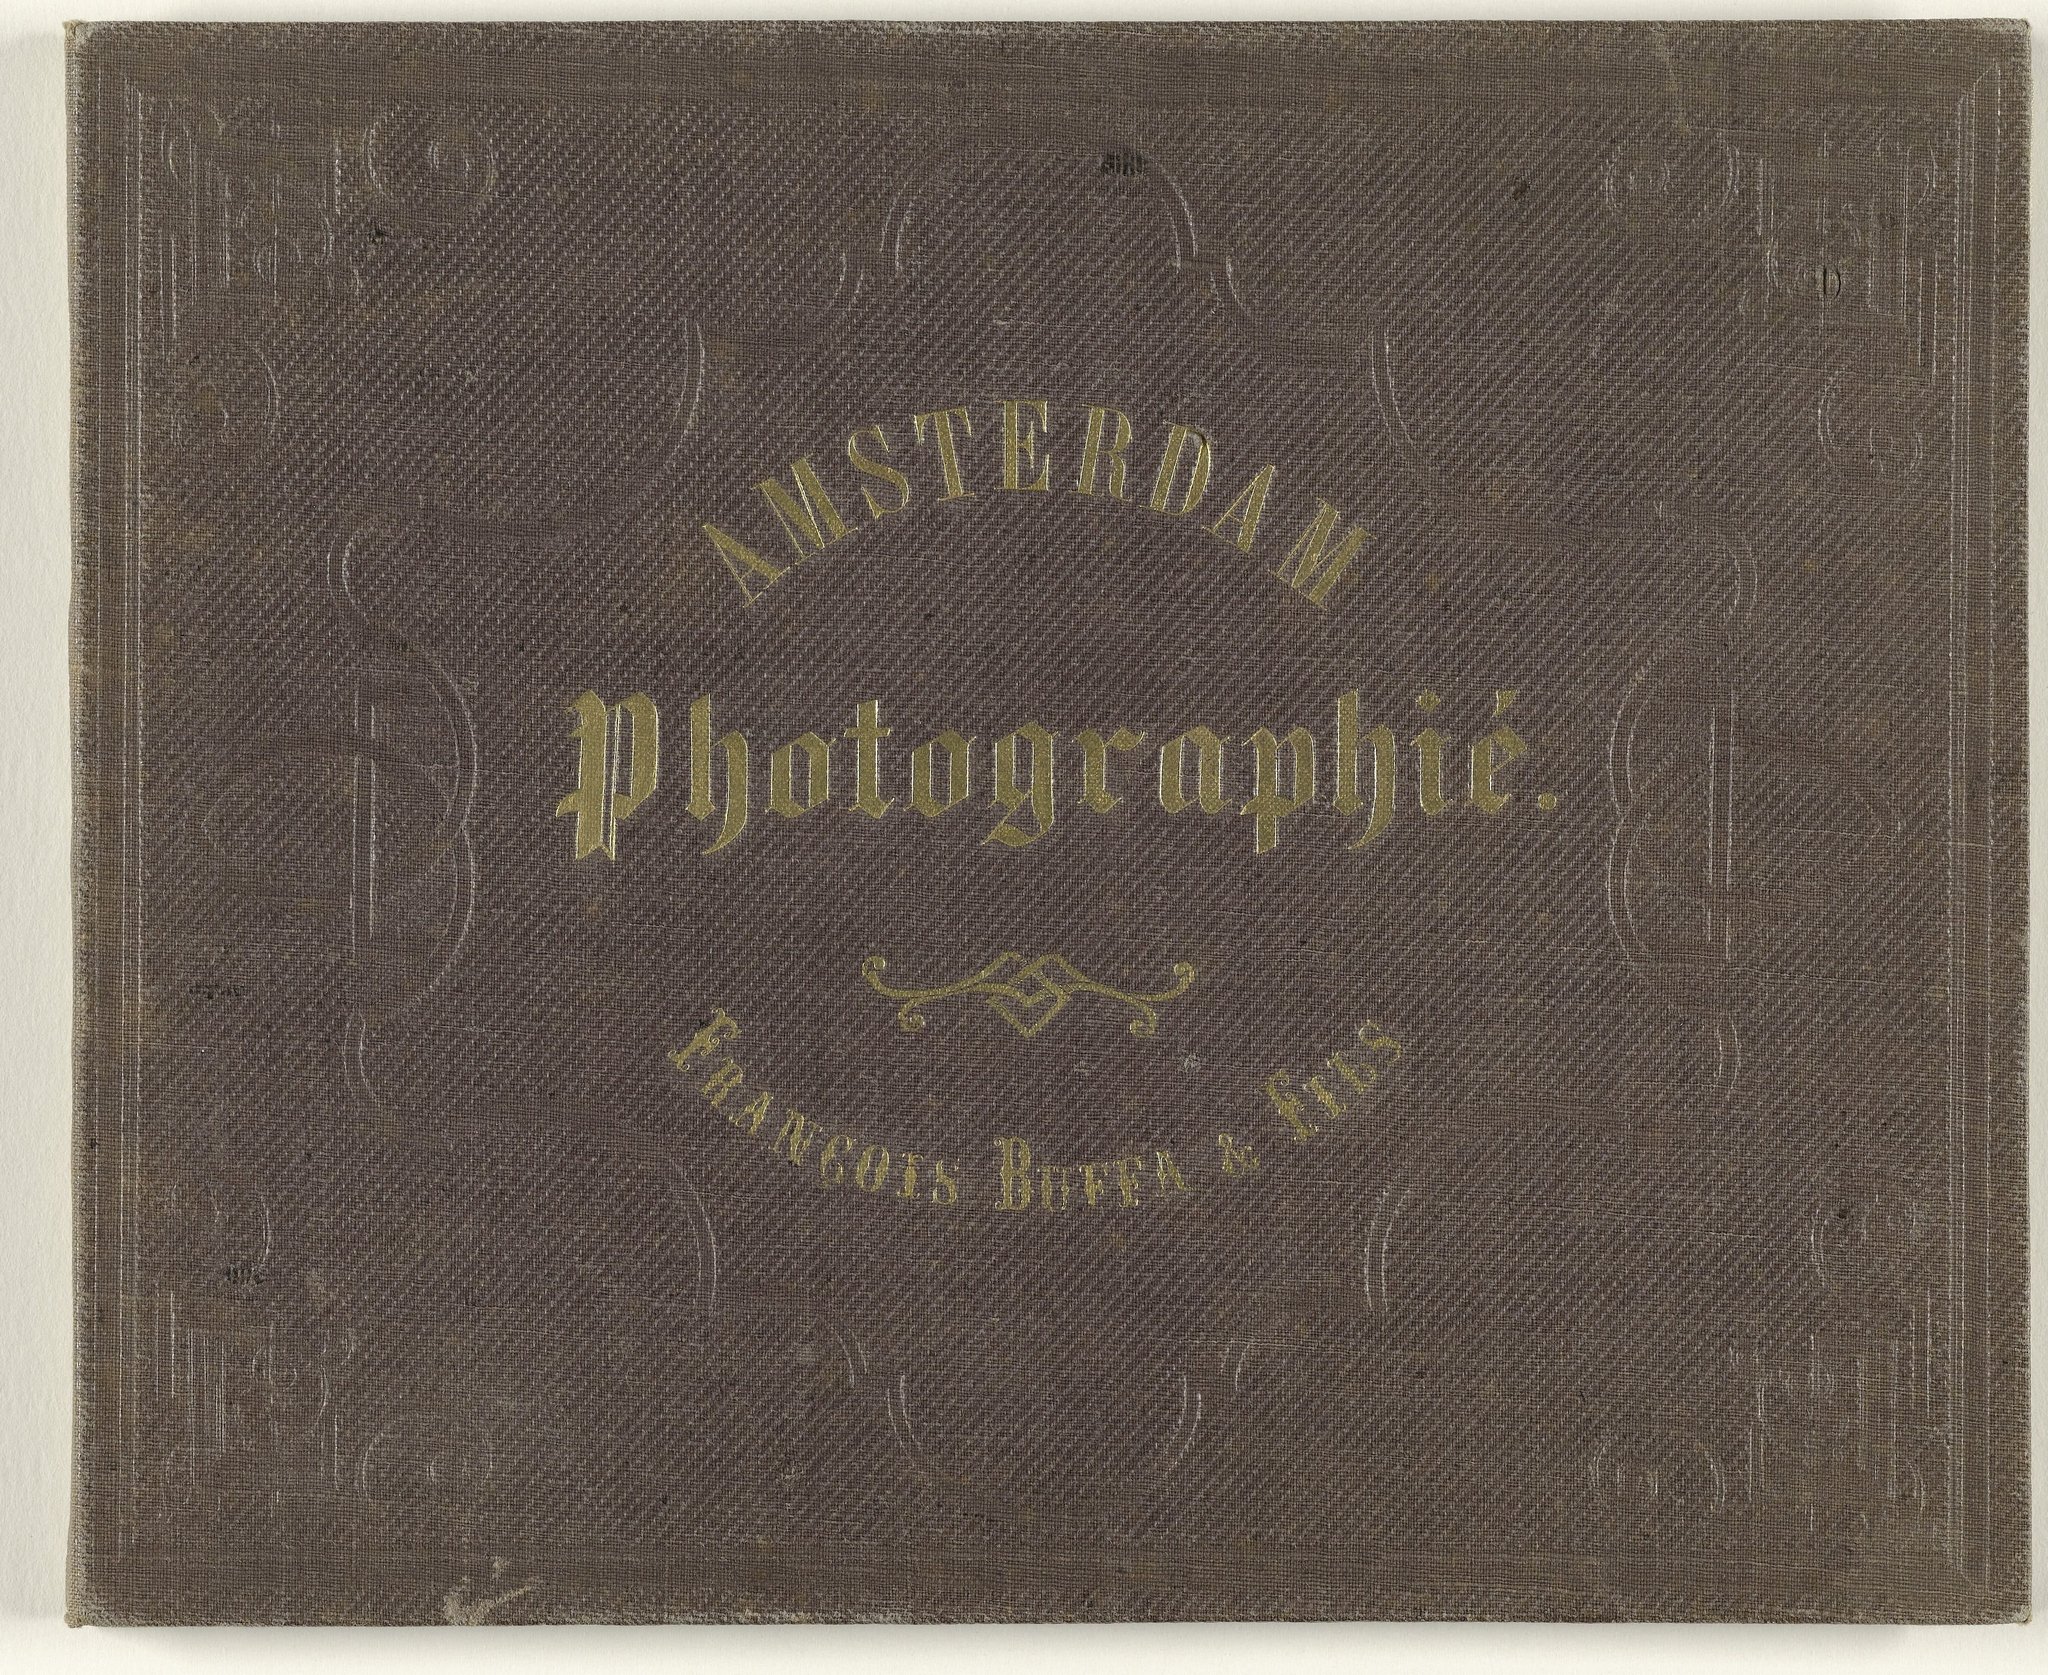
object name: photograph album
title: Amsterdam photographié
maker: pieter oosterhuis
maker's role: draughtsman, print maker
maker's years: 1816-1885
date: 1860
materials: cardboard, paper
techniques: albumen print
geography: amsterdam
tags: amsterdam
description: Leporelloalbum met twaalf stadsgezichten van Amsterdam.